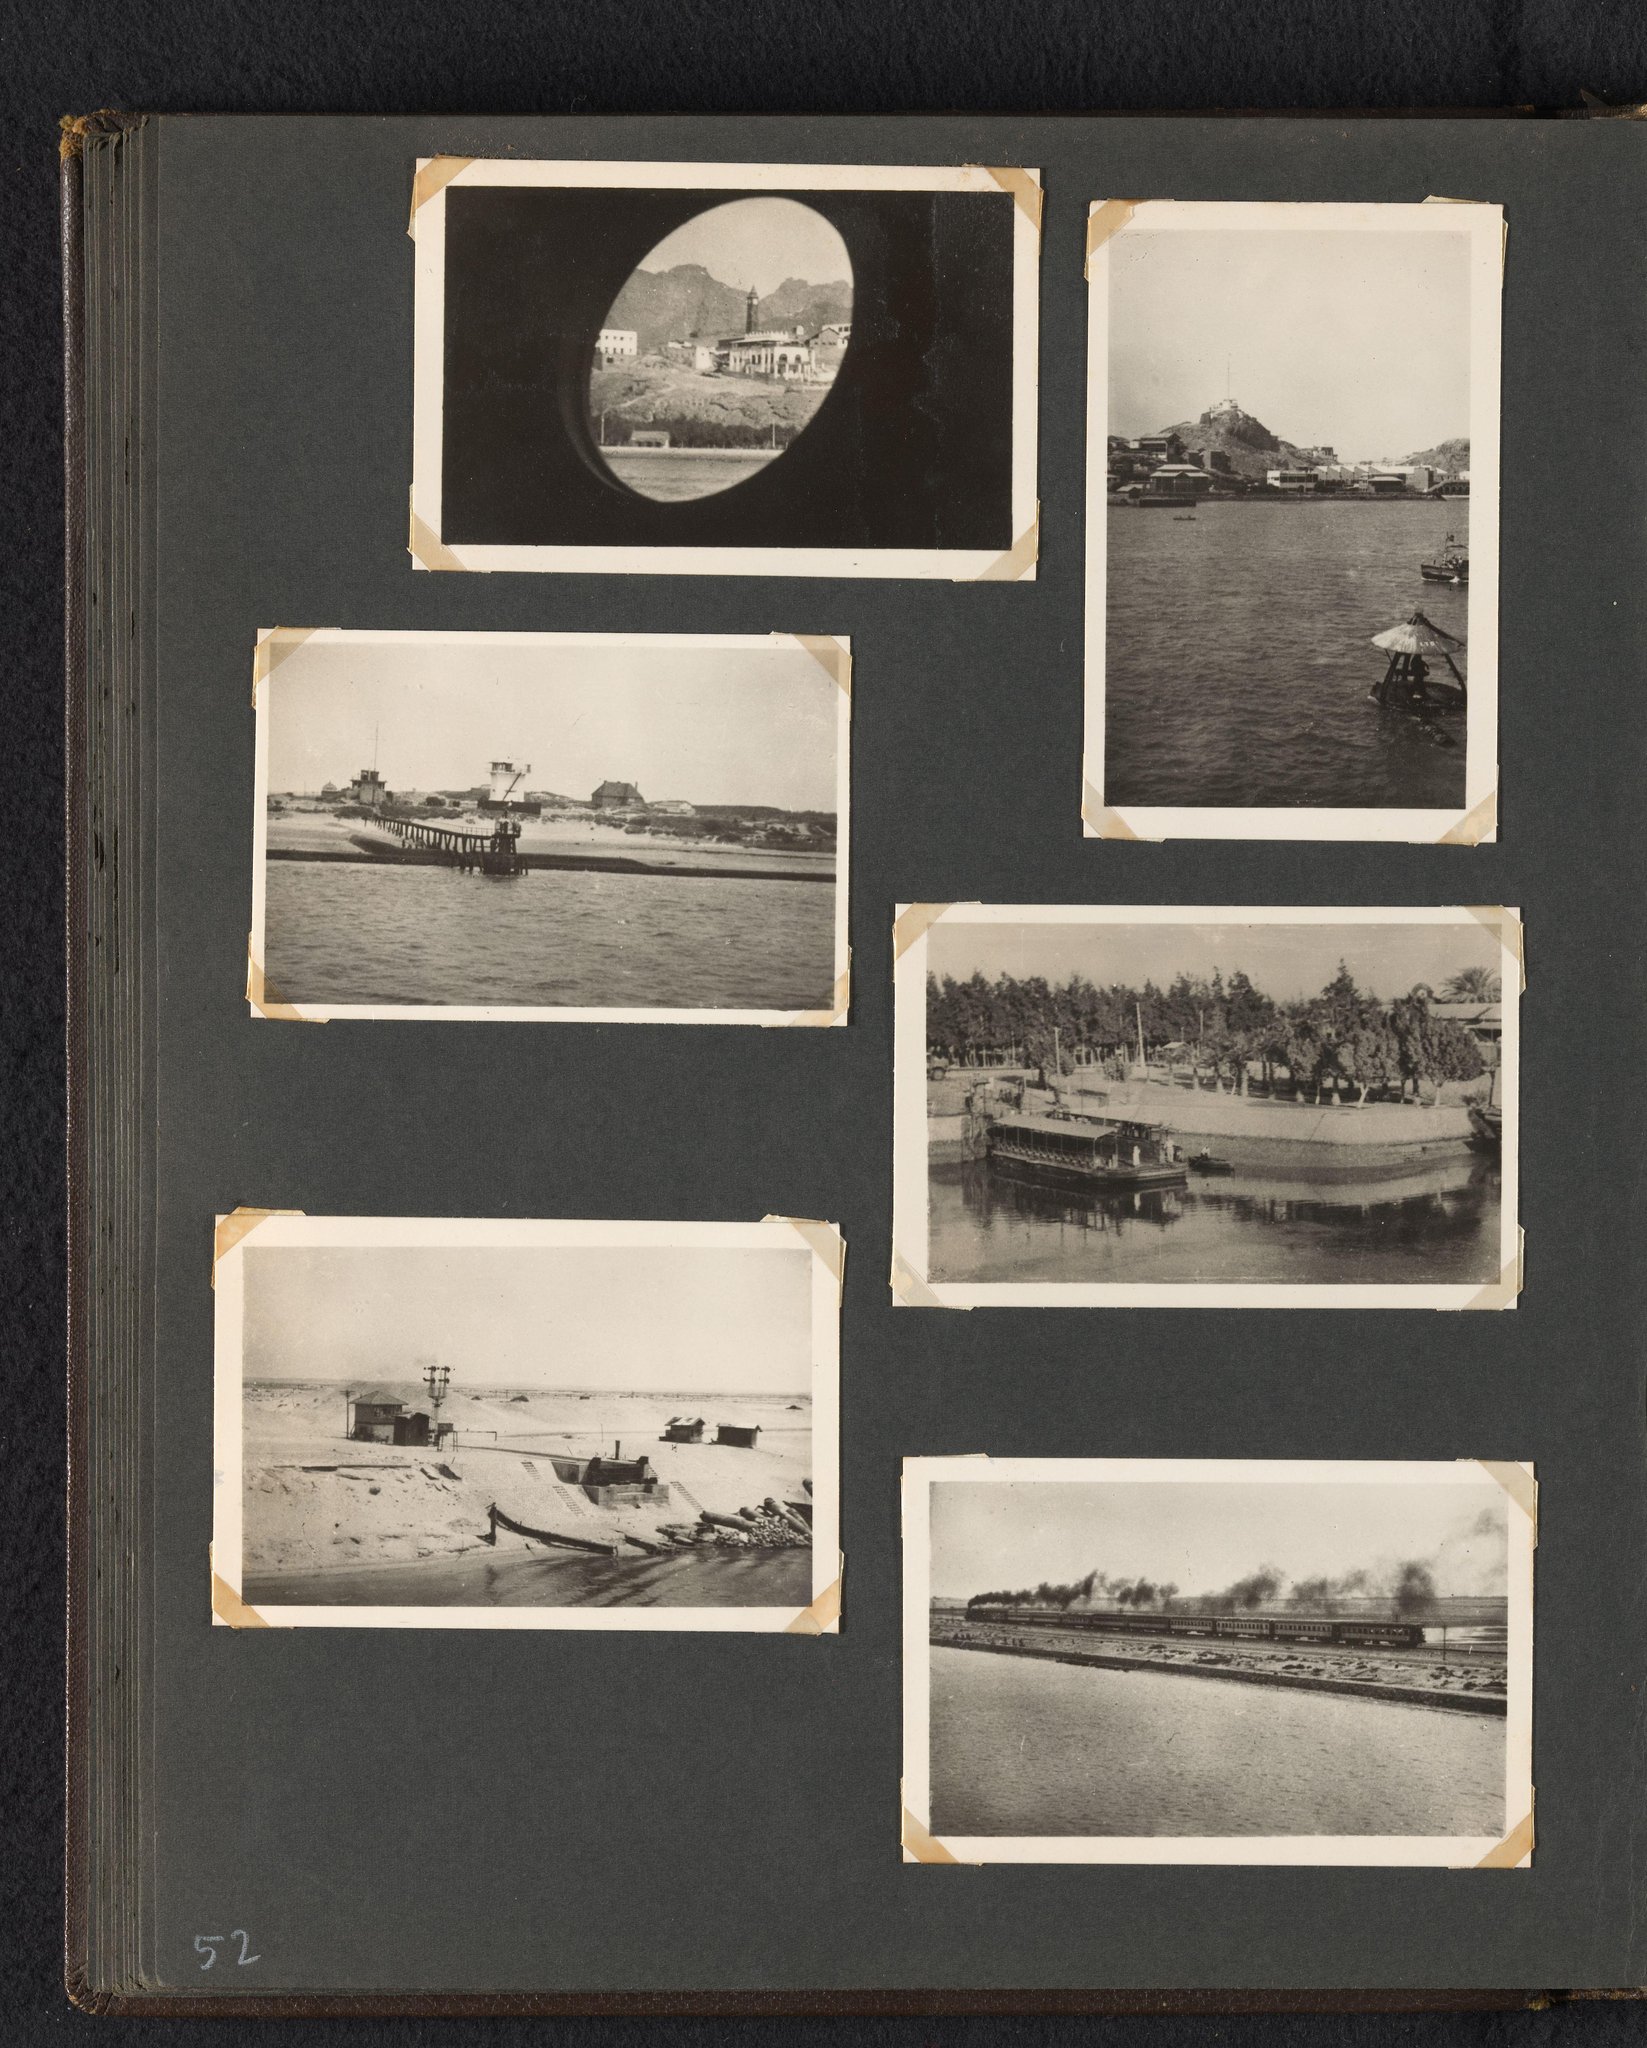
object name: album leaf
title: Vanaf een schip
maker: Anonymous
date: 1950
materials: cardboard, photographic support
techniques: gelatin silver print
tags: harbour, passenger train, coast, dutch east indies, the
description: Albumblad met zes foto's van bouwwerken, steigers, havengebouwen, spoorlijn aan de kust, genomen vanaf een schip op zee tijdens de terugreis naar Nederland. Mogelijk omgeving Suezkanaal. Onderdeel van het fotoalbum 'Mijn jaren in Indië' met foto's over de militaire acties in Nederlands-Indië.